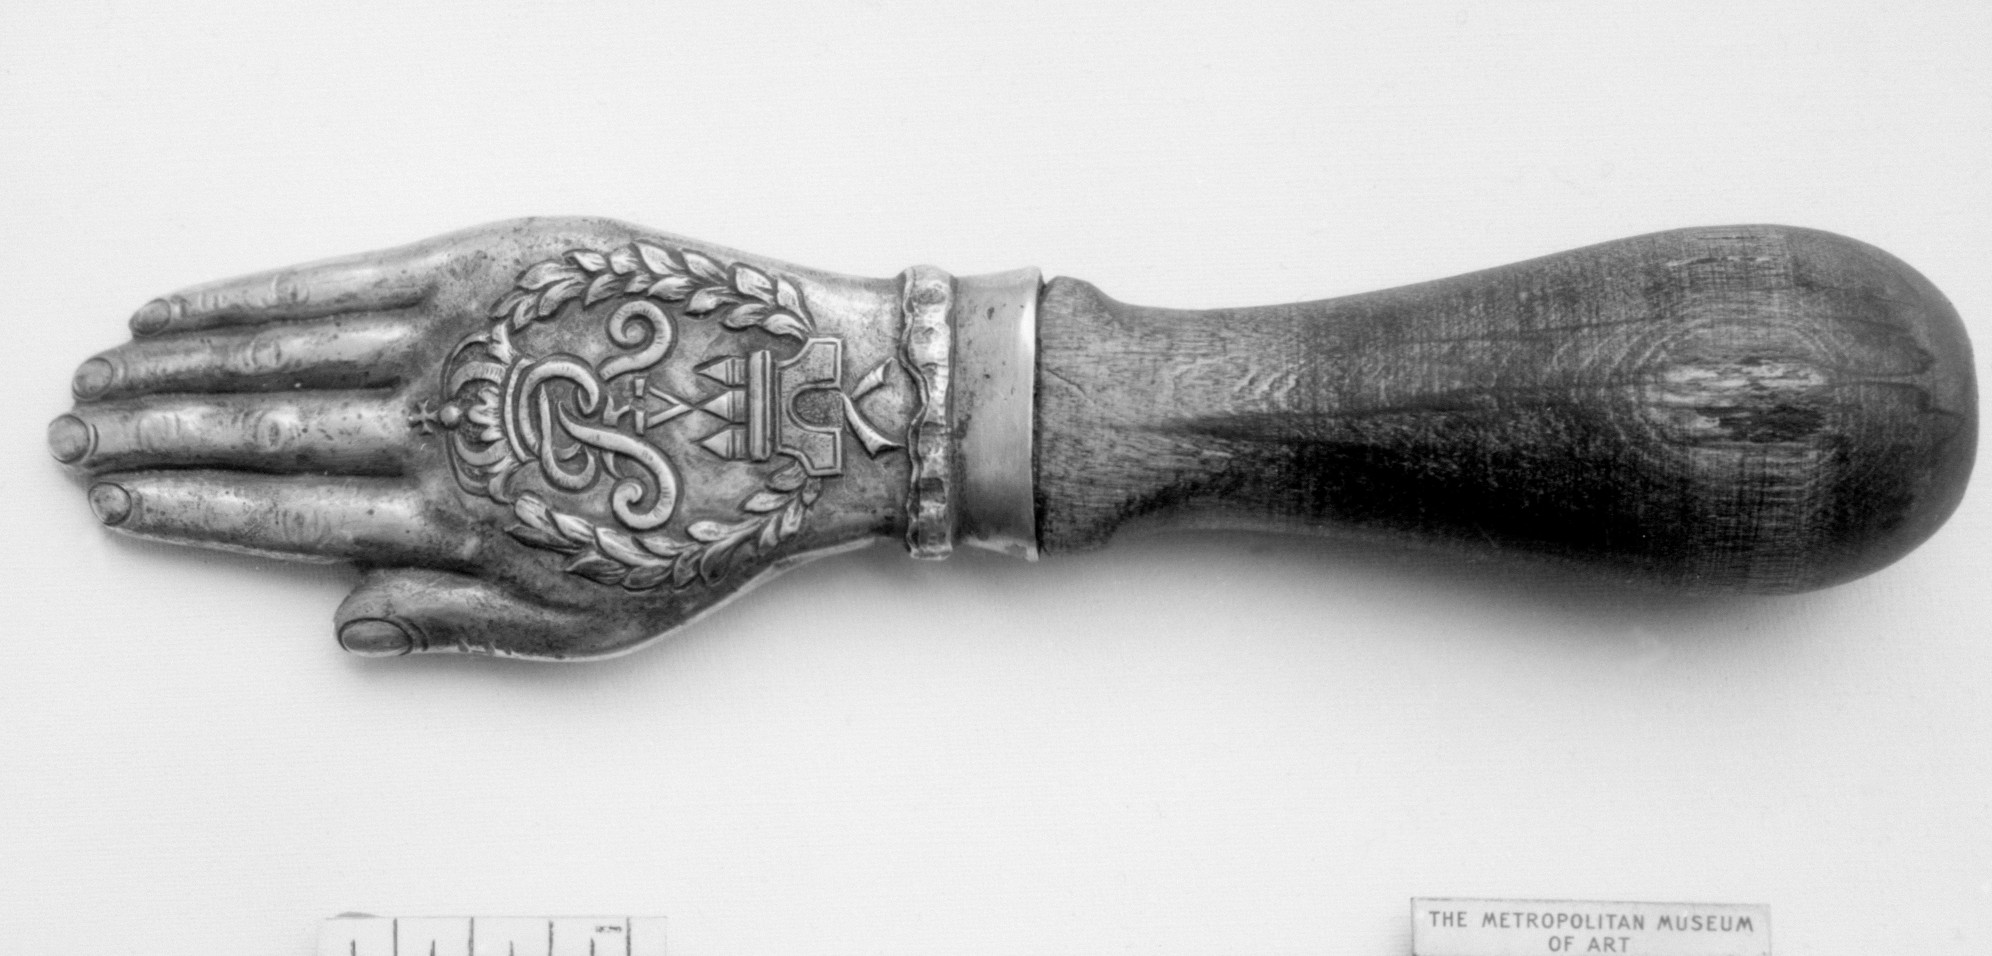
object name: sheriff's truncheon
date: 1746-1766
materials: silver, wood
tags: hands,coat of arms